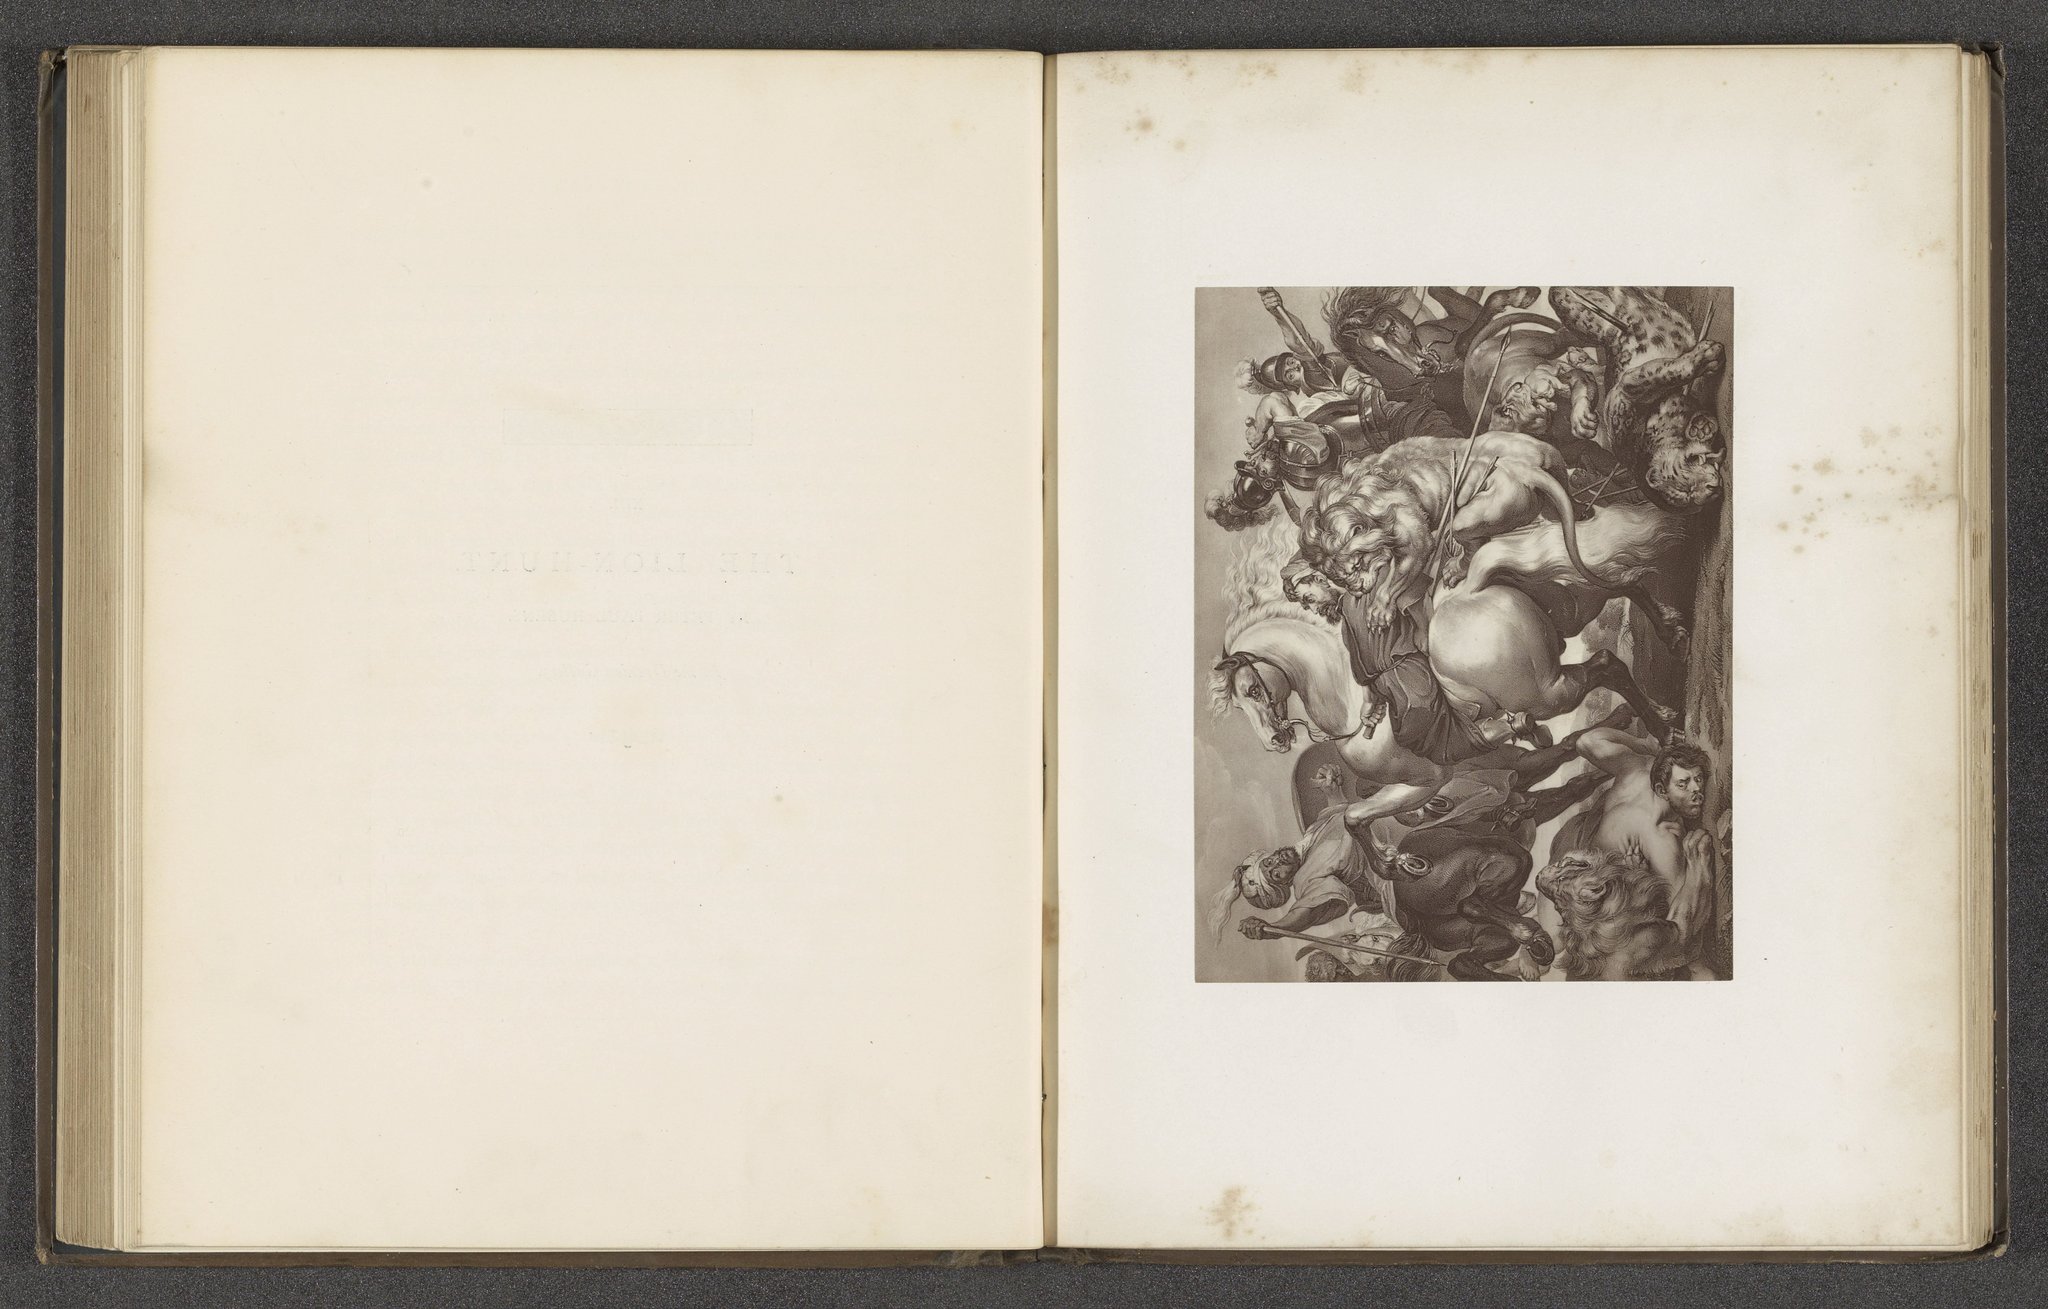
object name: photomechanical print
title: Fotoreproductie van een prent, voorstellende een leeuwenjacht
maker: Anonymous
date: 1859-1869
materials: paper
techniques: woodburytype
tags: hunter fighting a lion, lion hunt